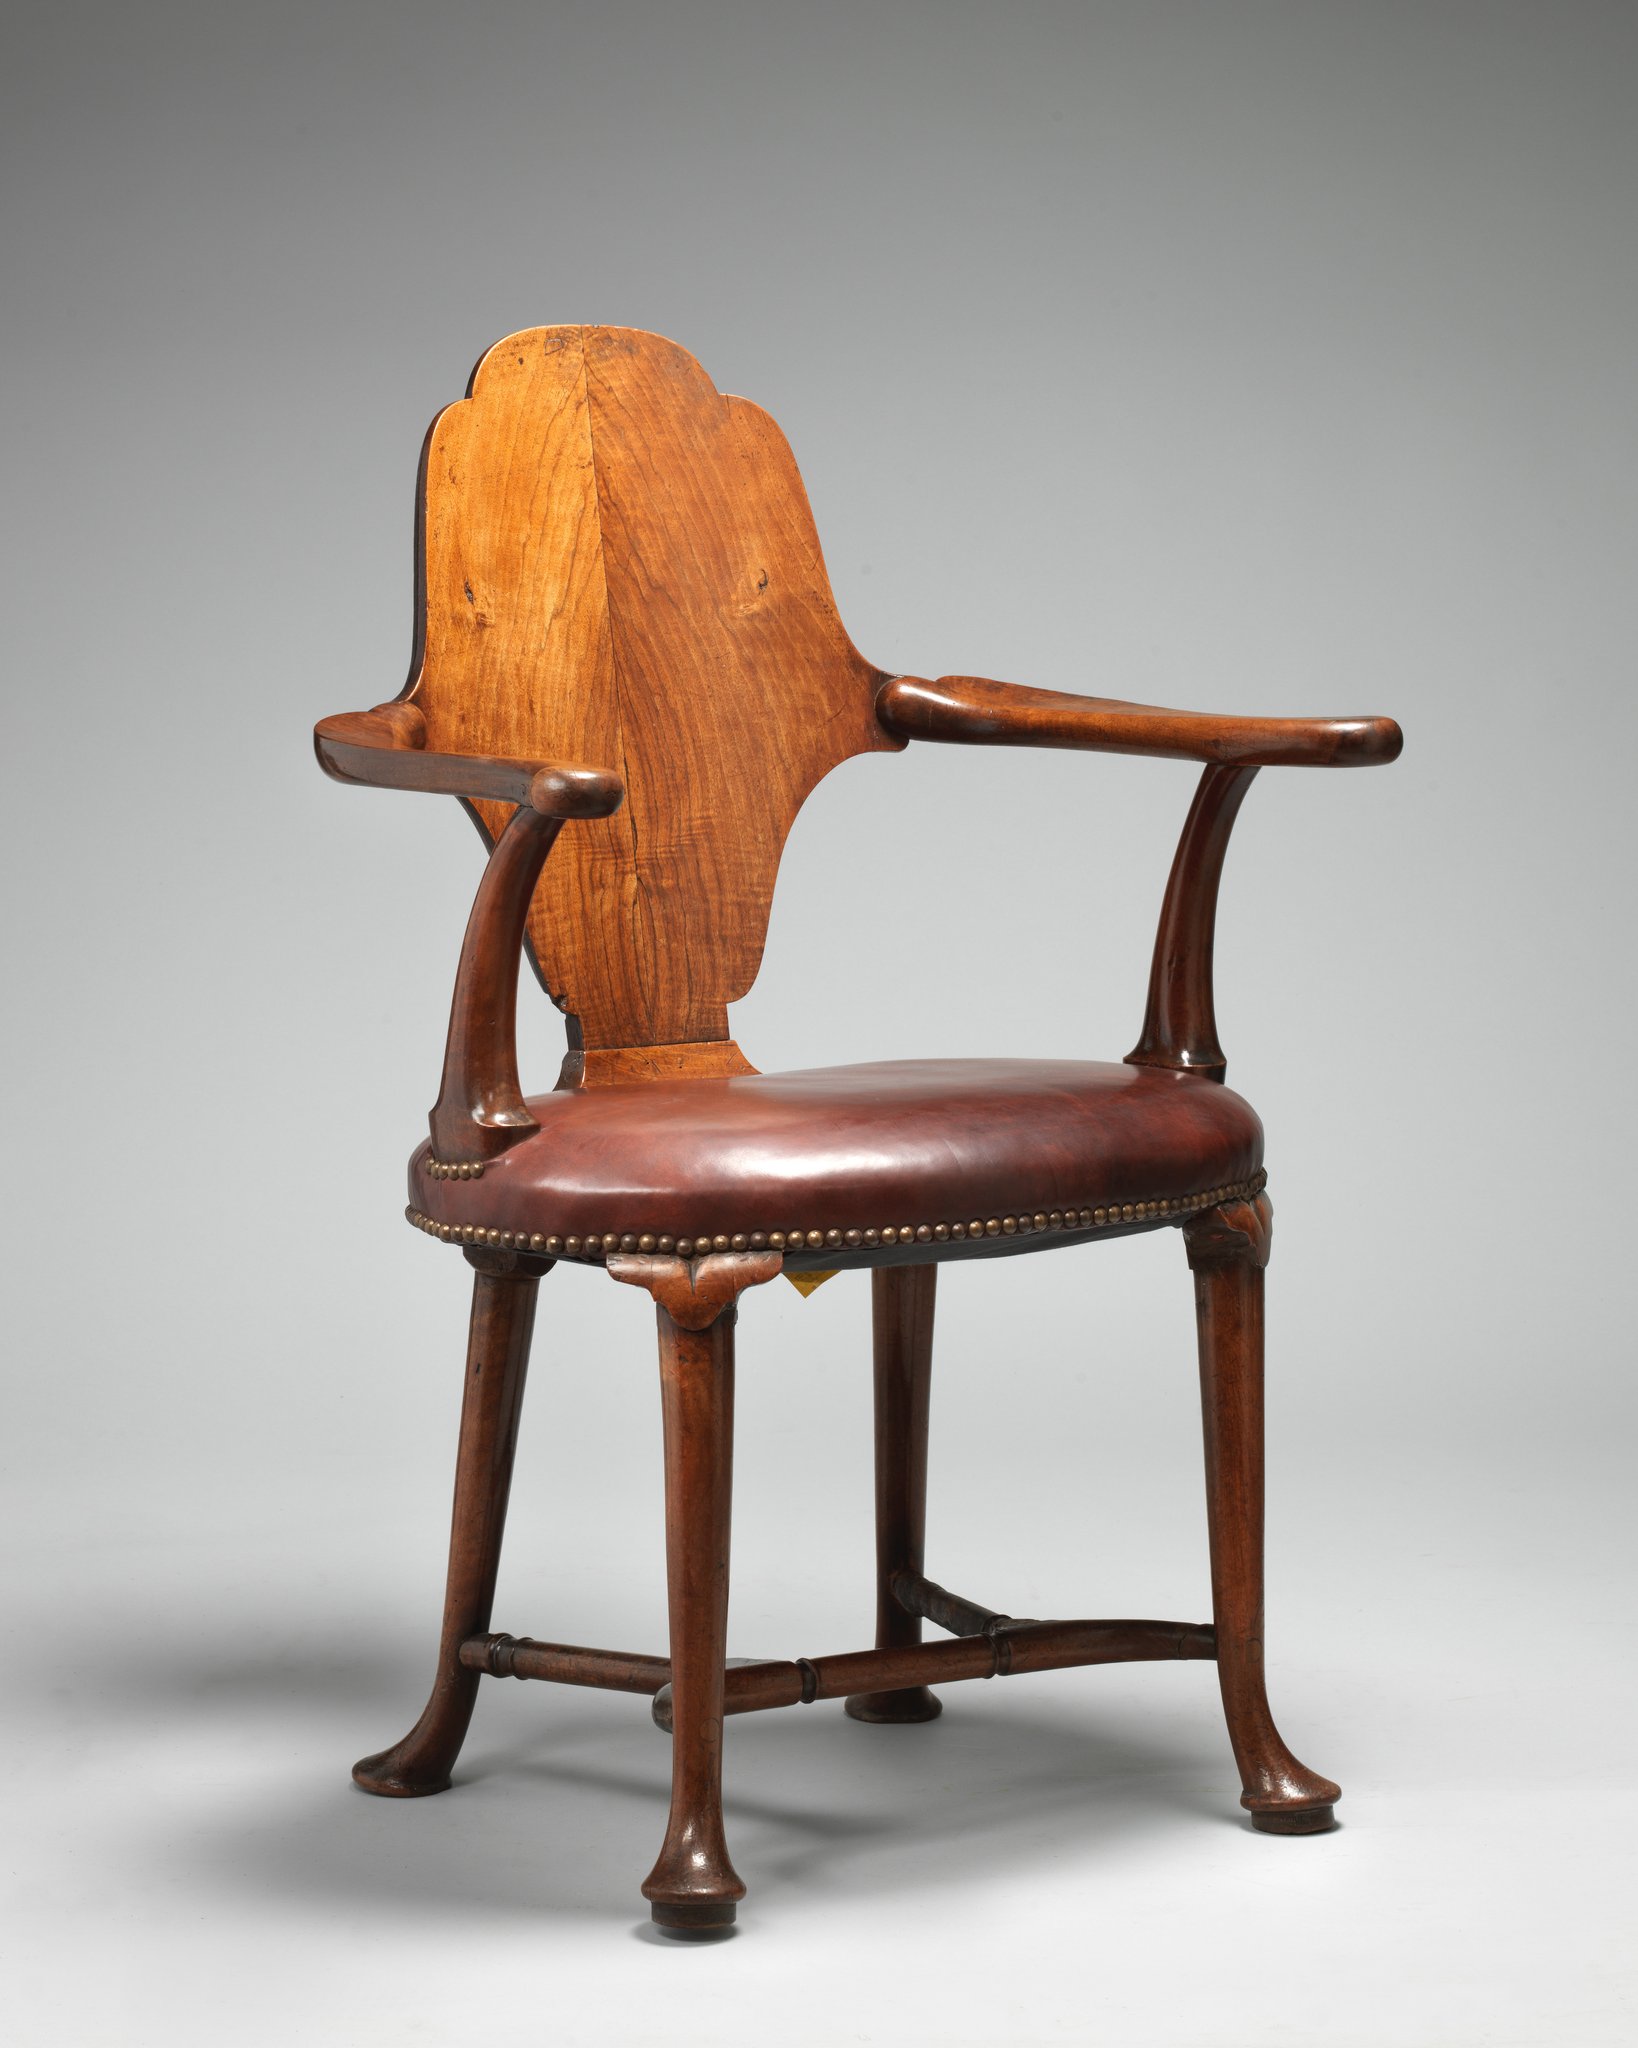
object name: armchair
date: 1710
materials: wood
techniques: veneering